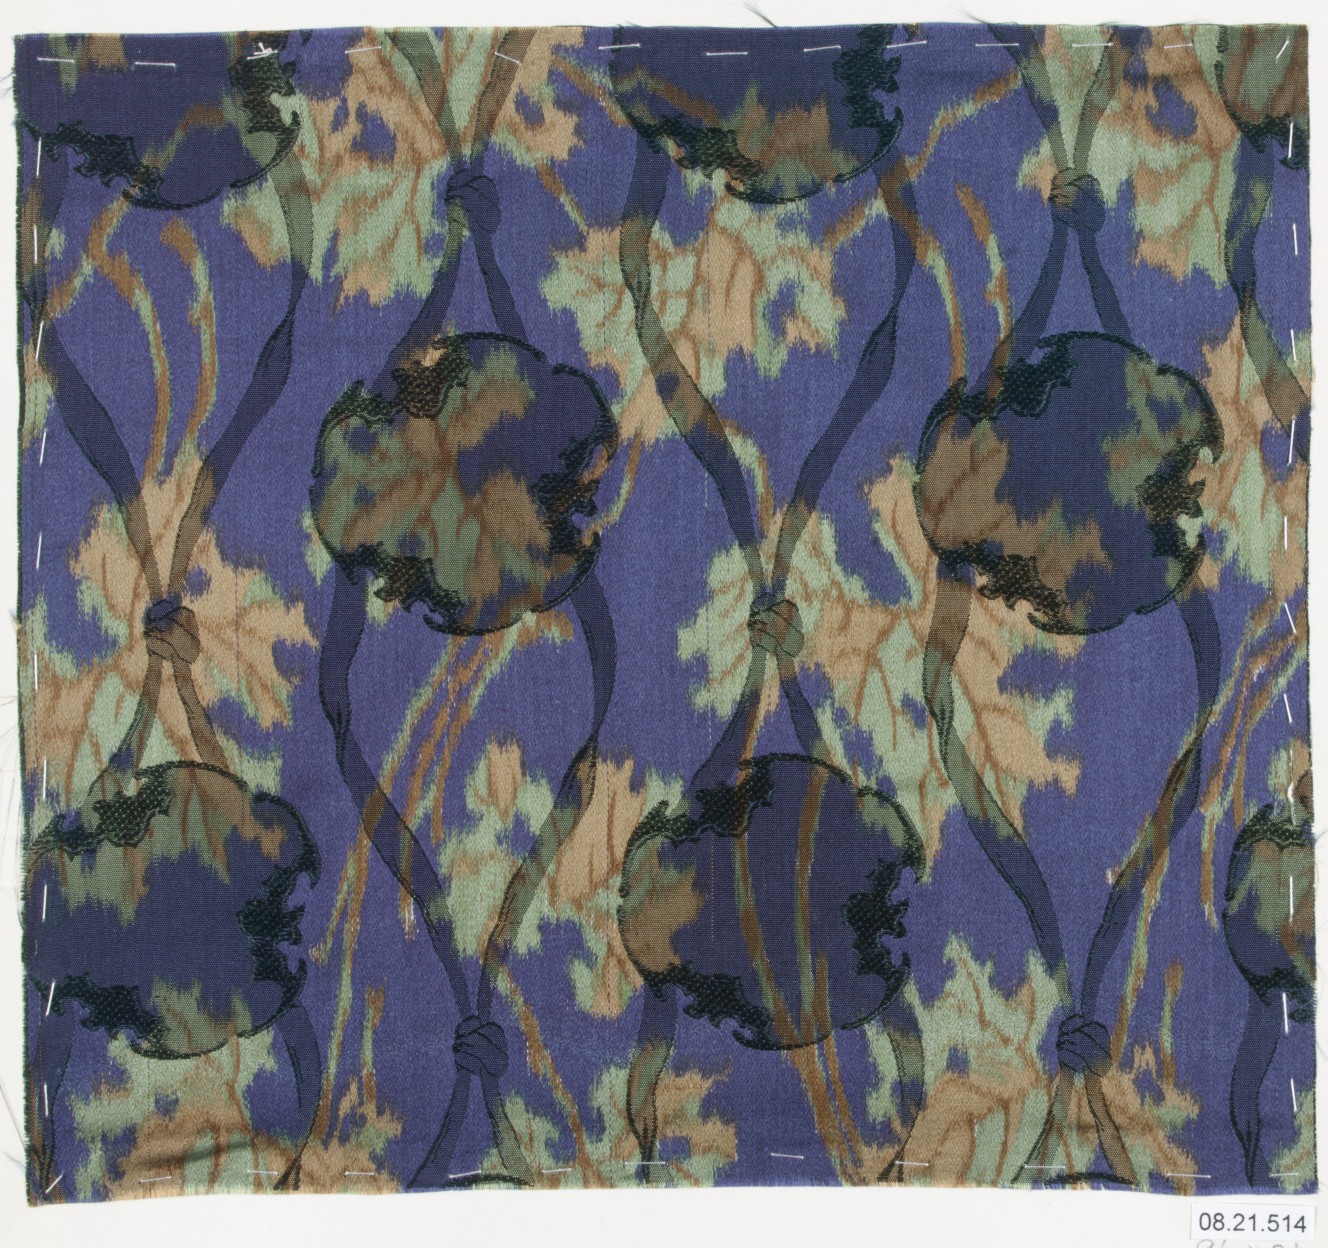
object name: textile sample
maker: Anonymous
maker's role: designer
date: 1900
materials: silk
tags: leaves